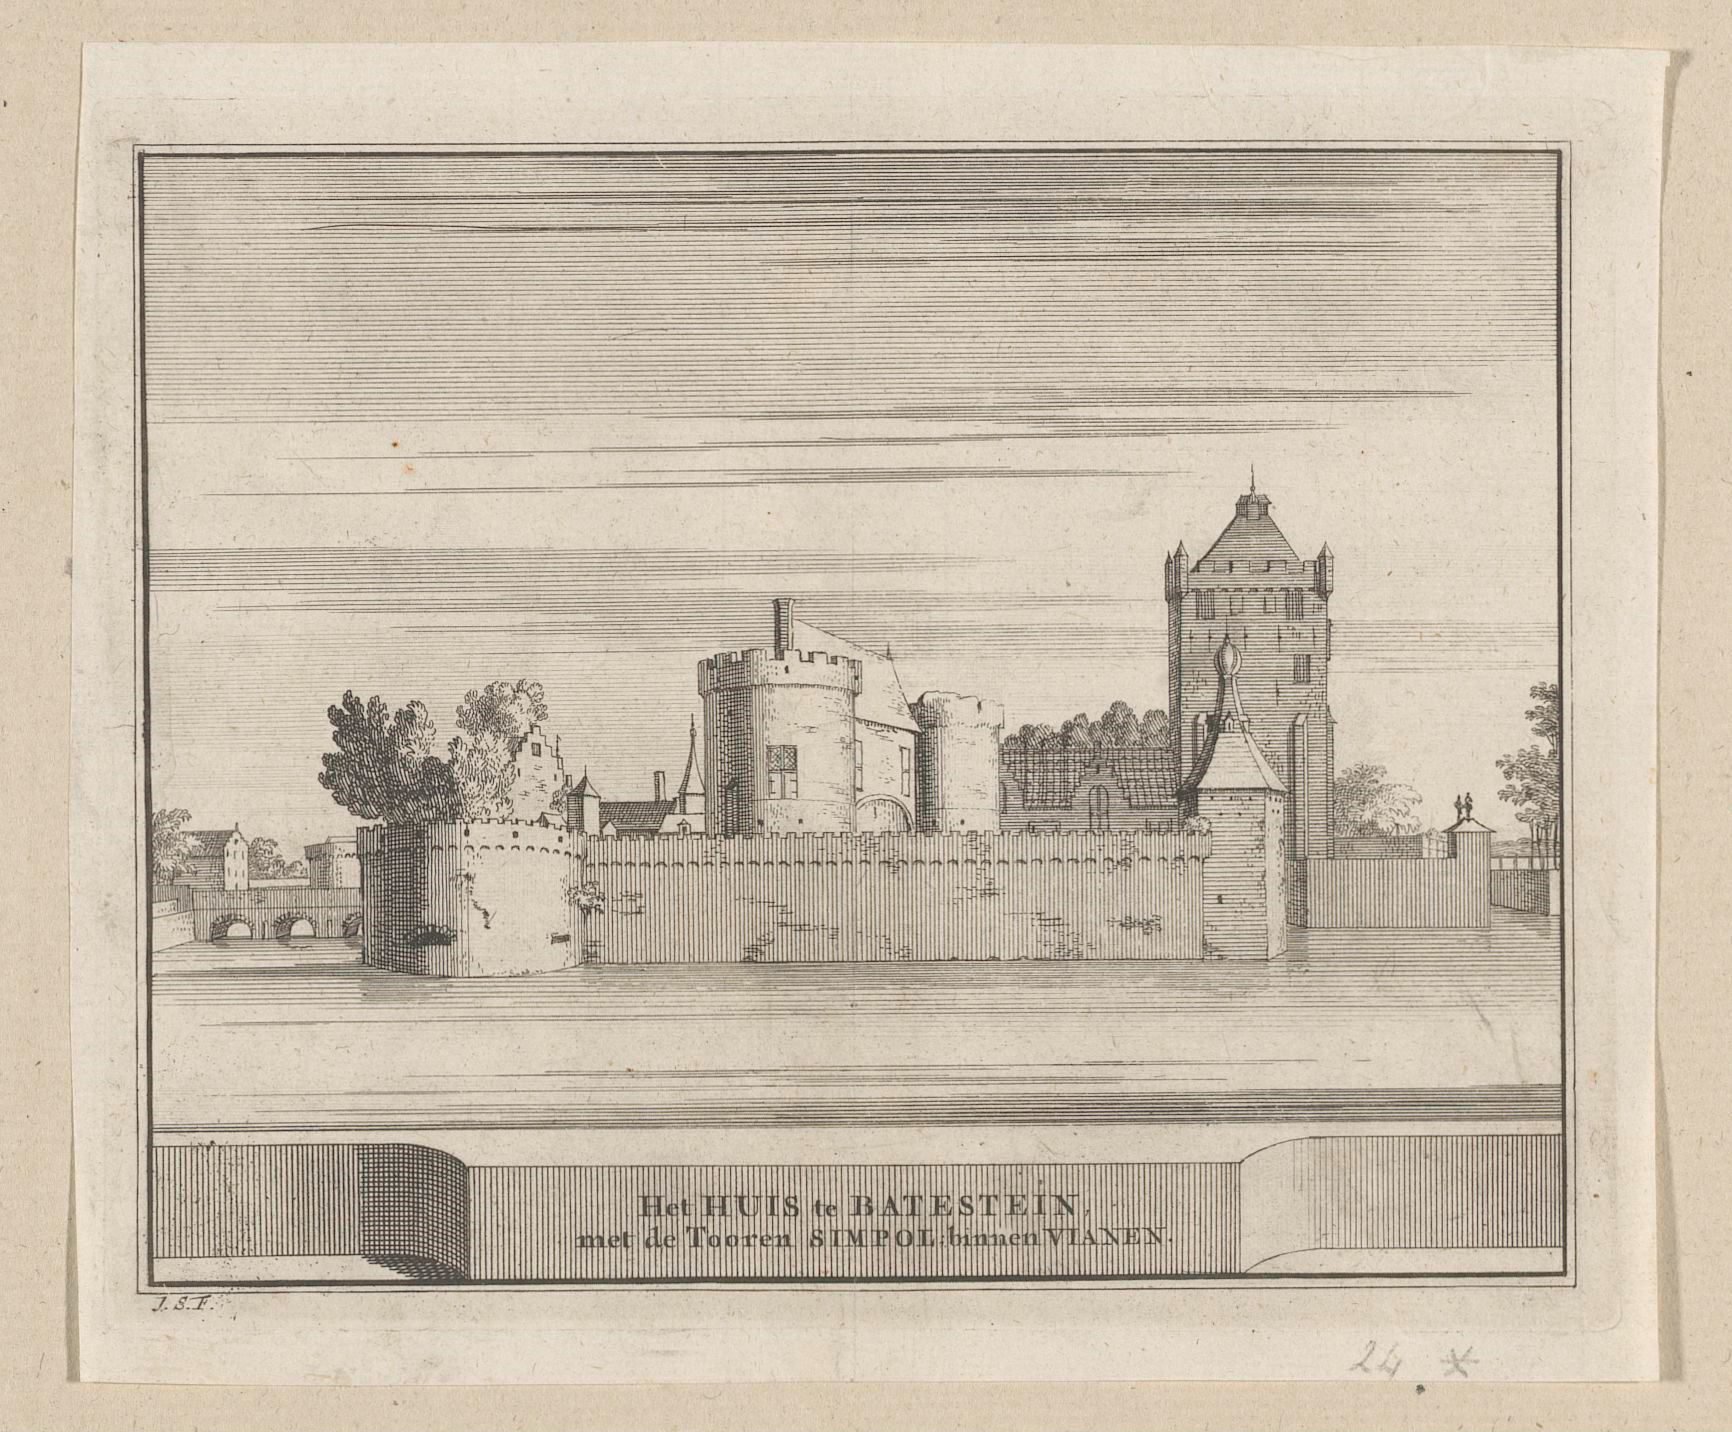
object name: print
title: Het Huis te Batestein met de tooren Simpol; binnen Vianen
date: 1711-1774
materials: paper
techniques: etching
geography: amsterdam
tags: castle, bridge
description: Prent ook gebruikt in: Smids, Ludolf. Schatkamer der Nederlandsse oudheden; of woordenboek, behelsende Nederlands steden en dorpen, kasteelen, sloten en heeren huysen (…). Amsterdam: Pieter de Coup, 1711, tussen p. 28 en 29. Het is ook mogelijk dat deze prent uit de tweede (1737) of derde (1774) druk komt, of uit een uitgave met alleen de prenten: Nederlandsche oudheden, bestaande in zestig verbeeldingen (...) gelegen in Holland, 't Sticht van Utrecht en Gelderland enz. Amsterdam: Hendrik Bosch, 1721.